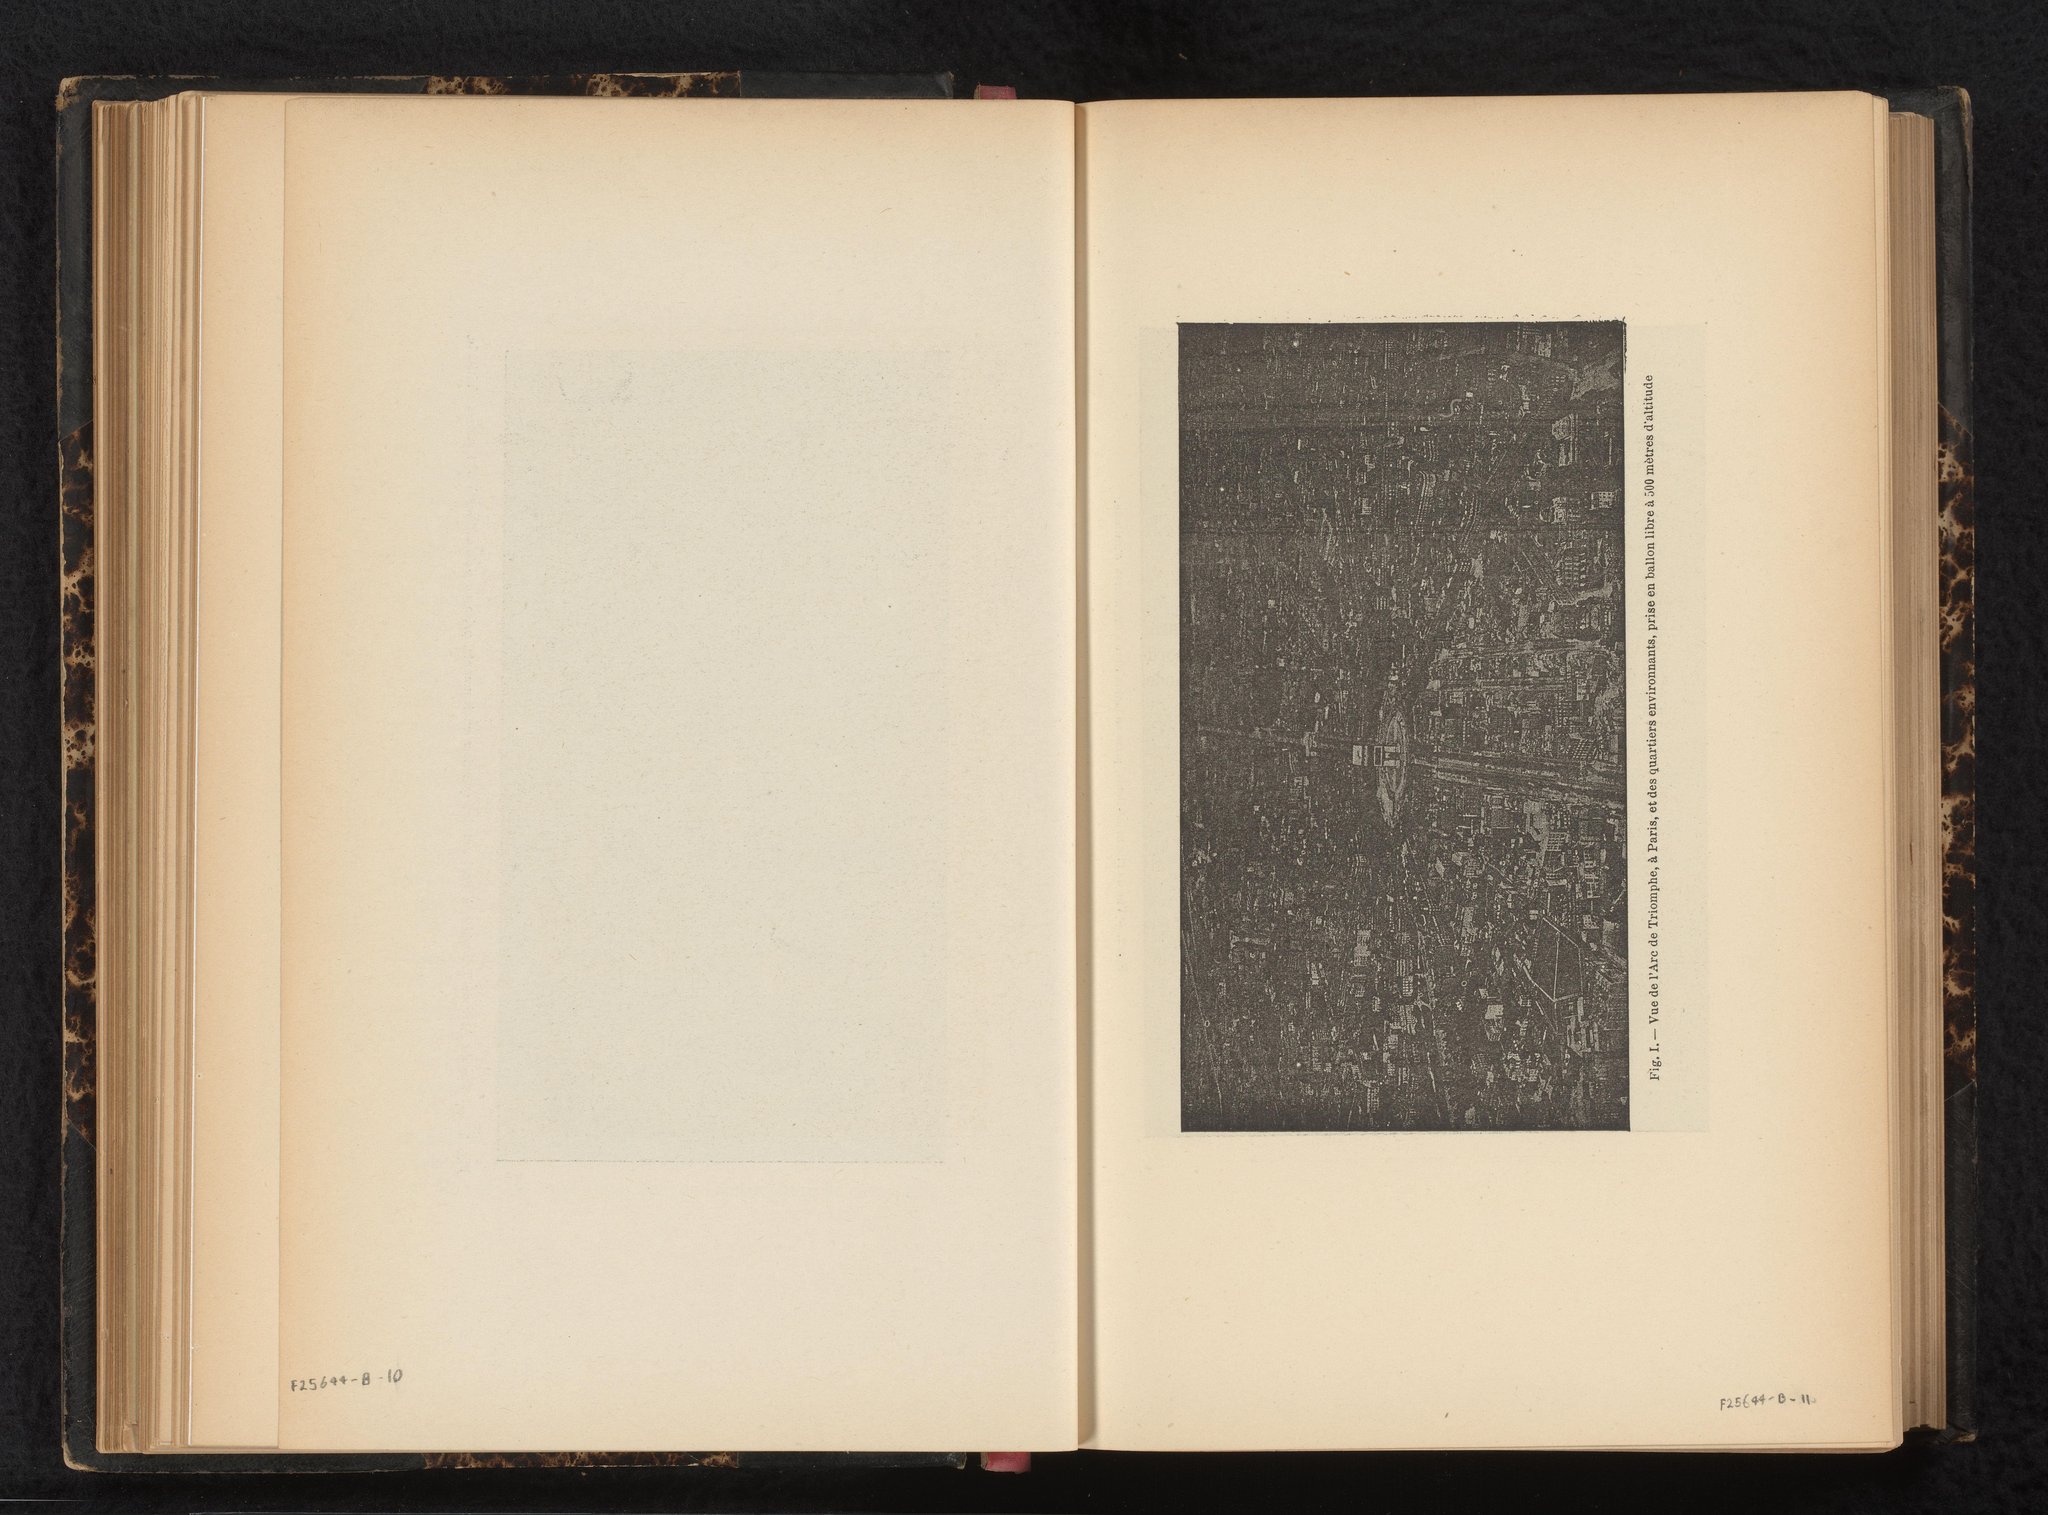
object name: photomechanical print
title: Vue de l'Arc de Triomphe, à Paris, et des quartiers environnants, prise en ballon libre à 500 mètres d'altitude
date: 1886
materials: paper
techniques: photoaquatint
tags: square, place, circus, etc., city-view in general; 'veduta'